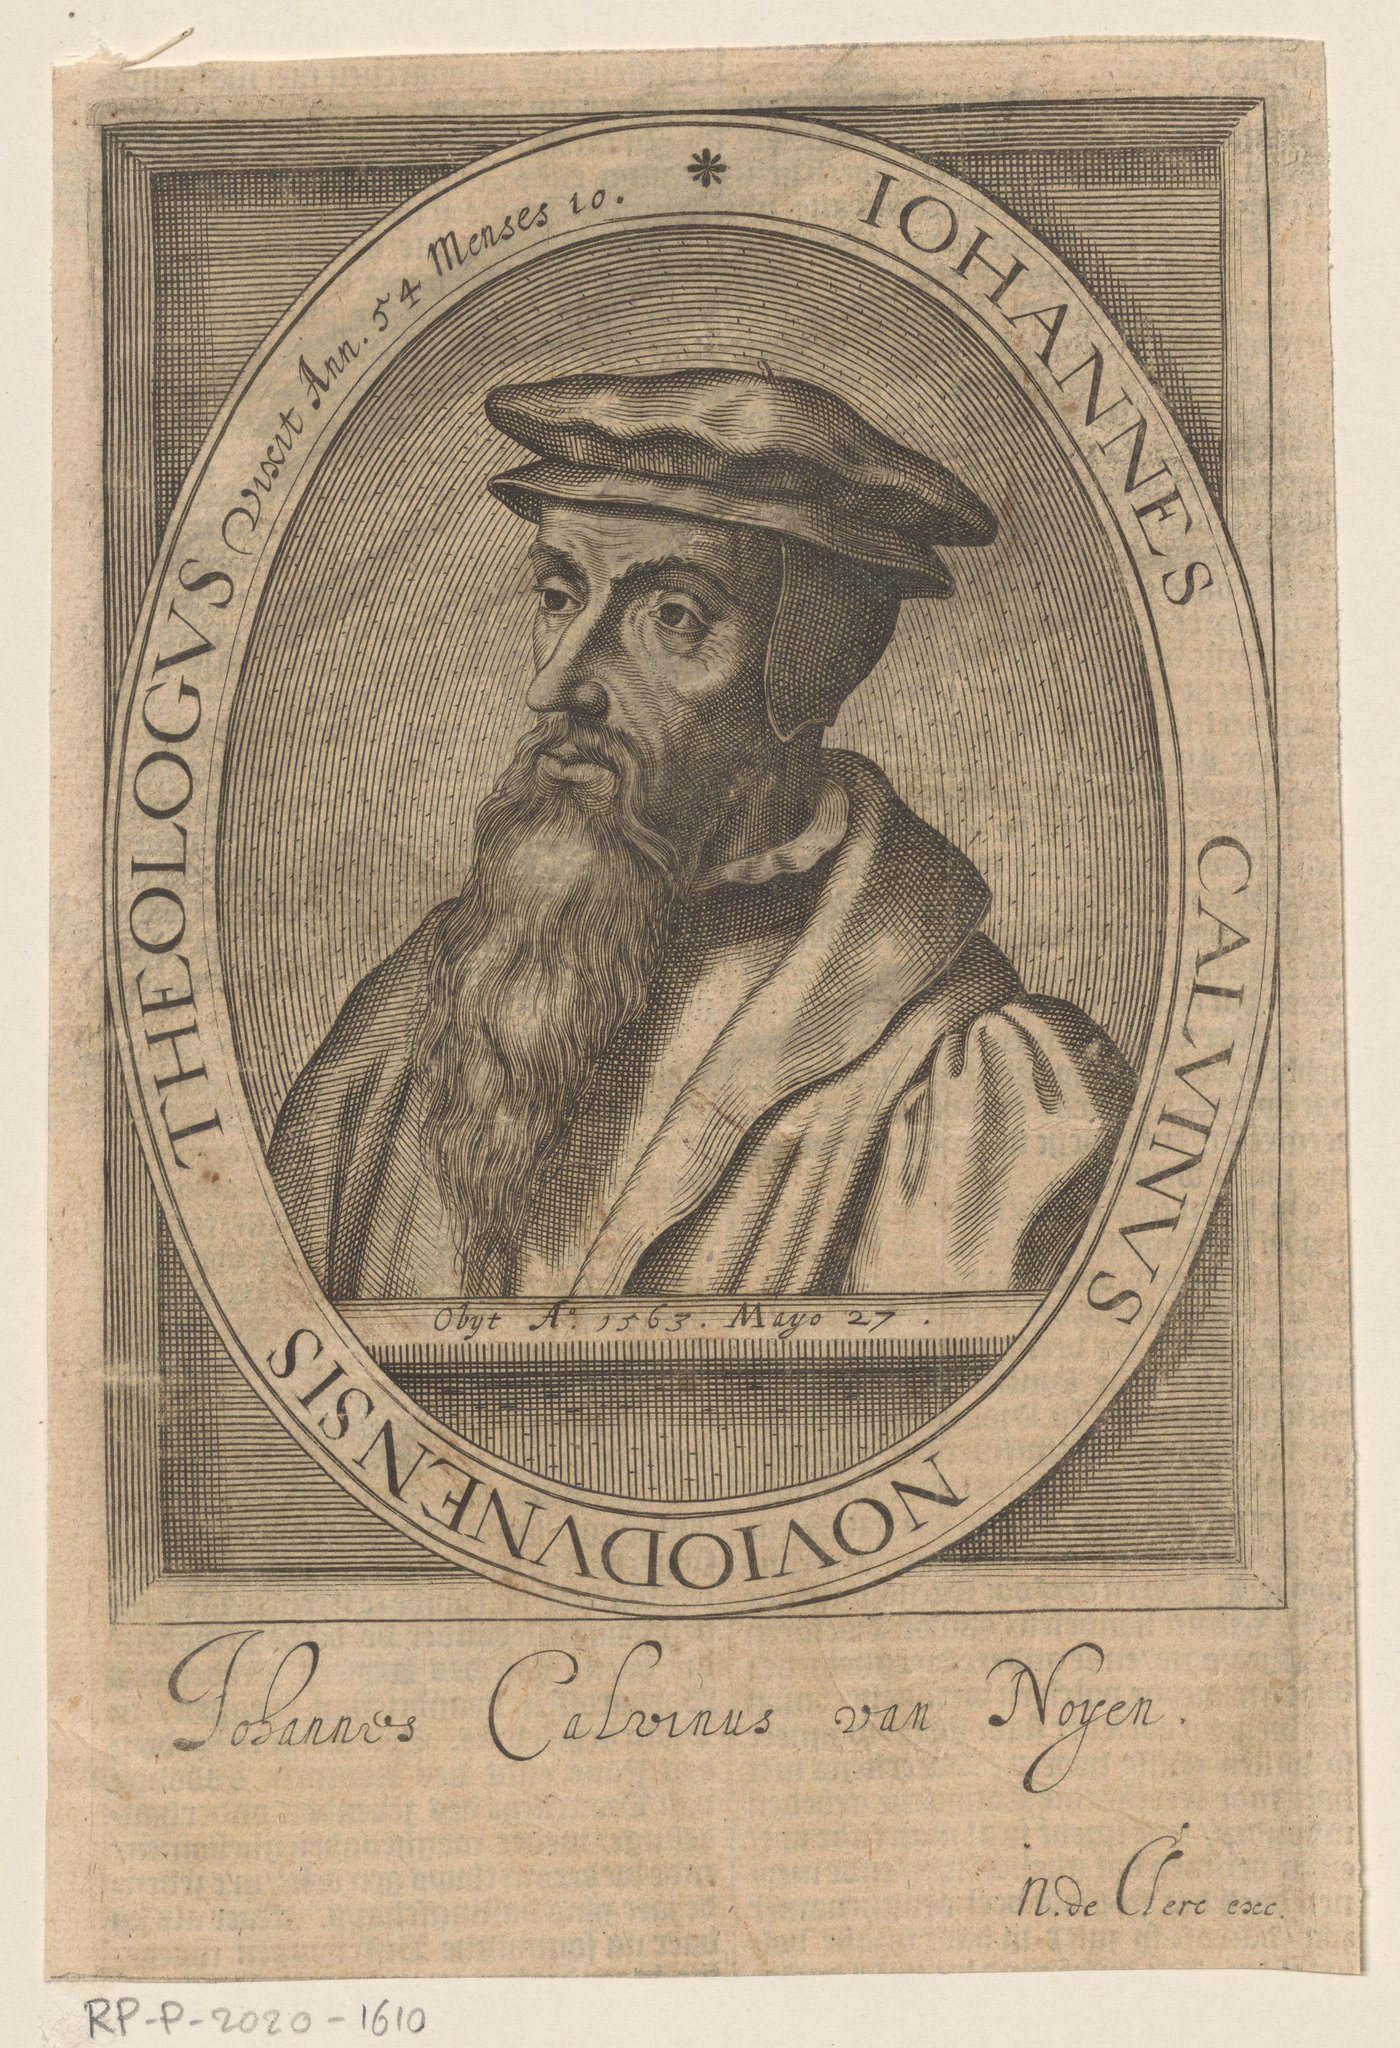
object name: print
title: Portret van Johannes Calvijn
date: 1599-1623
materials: paper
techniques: engraving, letterpress printing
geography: delft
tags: historical persons